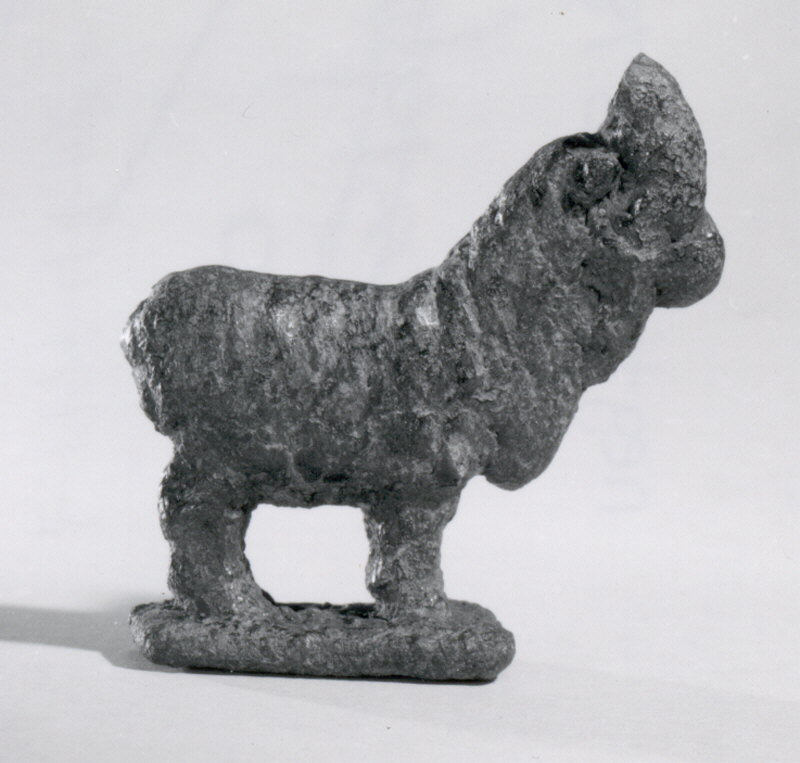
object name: sculpture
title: Figurine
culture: bactria-margiana archaeological complex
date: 2333-1668 BCE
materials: copper alloy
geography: bactria-margiana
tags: animals